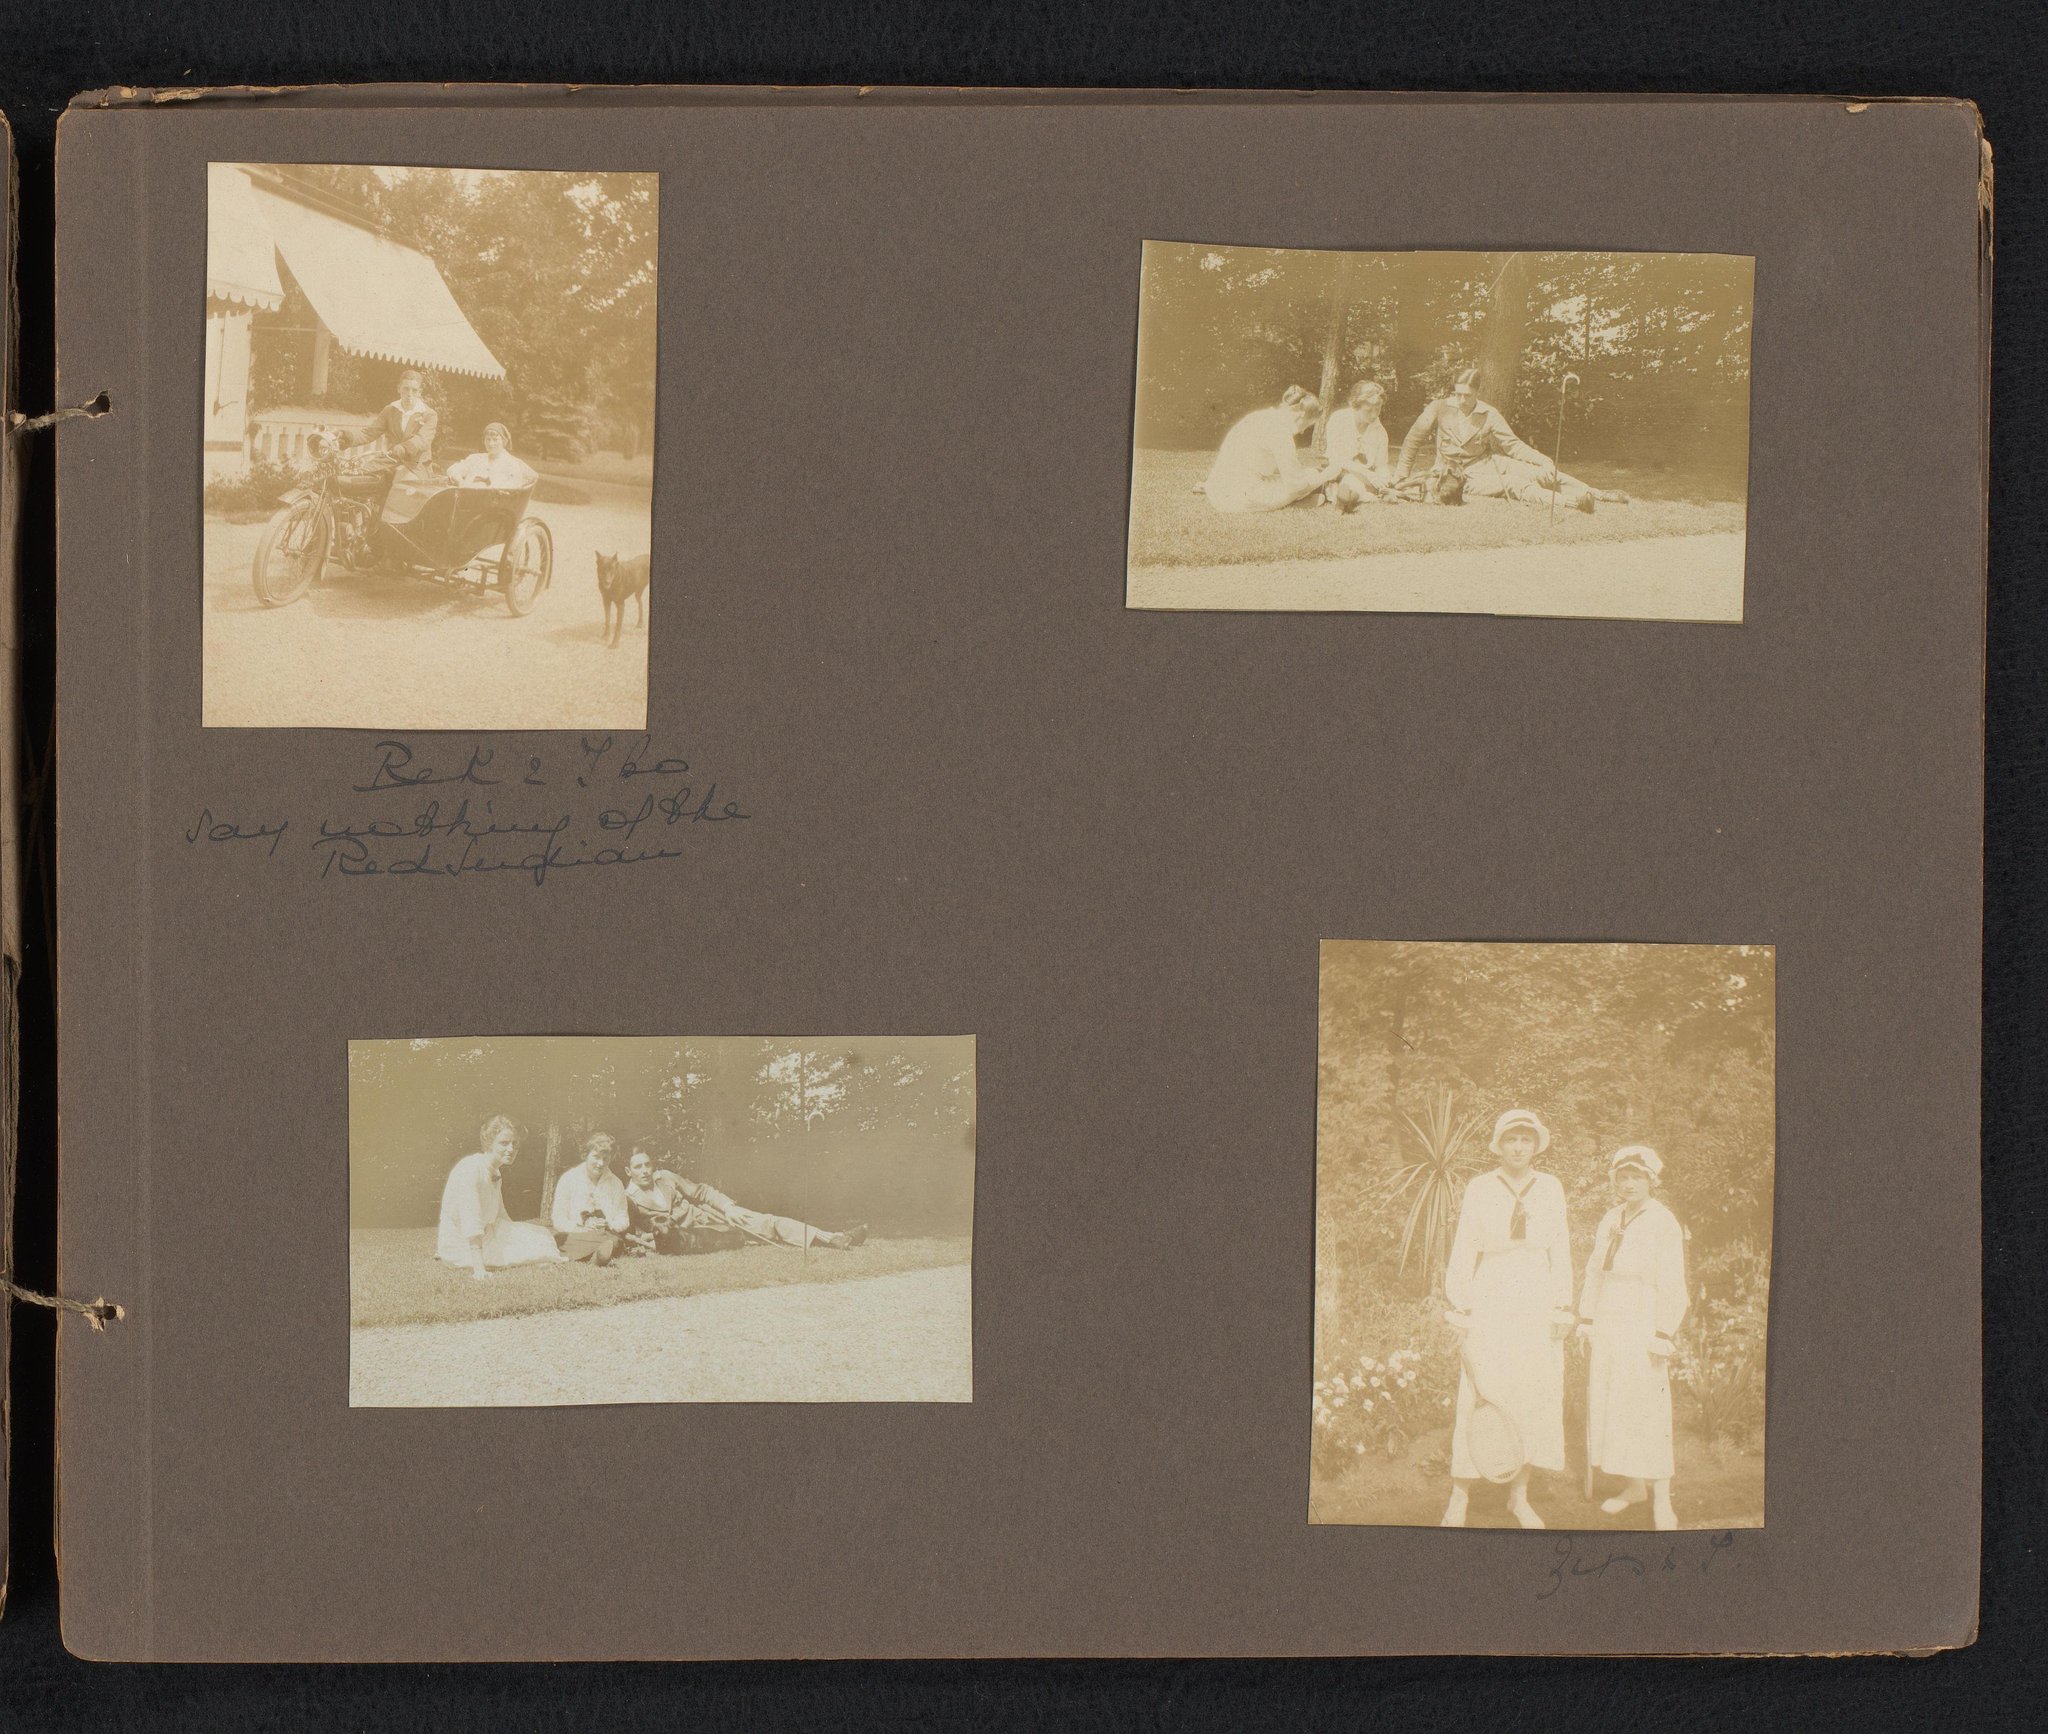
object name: album leaf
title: Vier foto's van vrienden van Loentje Onnen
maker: carolina frederika onnen (lien/loen)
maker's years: 1896-1983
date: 1914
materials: paper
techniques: gelatin silver print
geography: netherlands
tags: motor-cycles and other two-wheeled motor-vehicles, garden, friends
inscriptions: inscription: ‘Zus & T.’, inscription: ‘Bek & Tho/ say nothing of the/ Red Indian’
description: Deze foto's maken deel uit van een album.